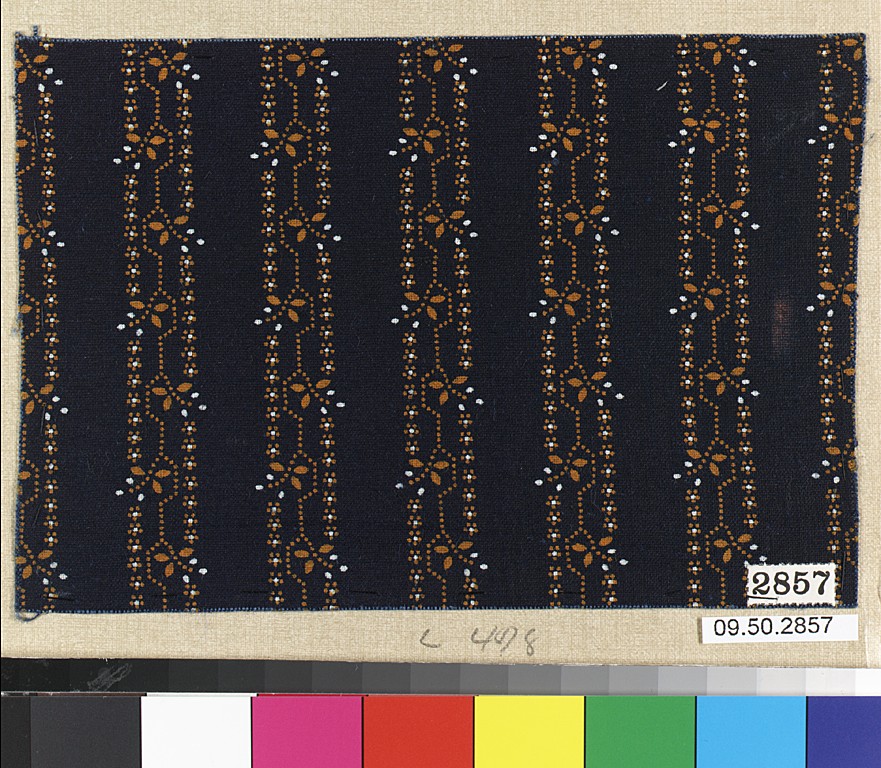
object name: piece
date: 1801-1900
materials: cotton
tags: leaves